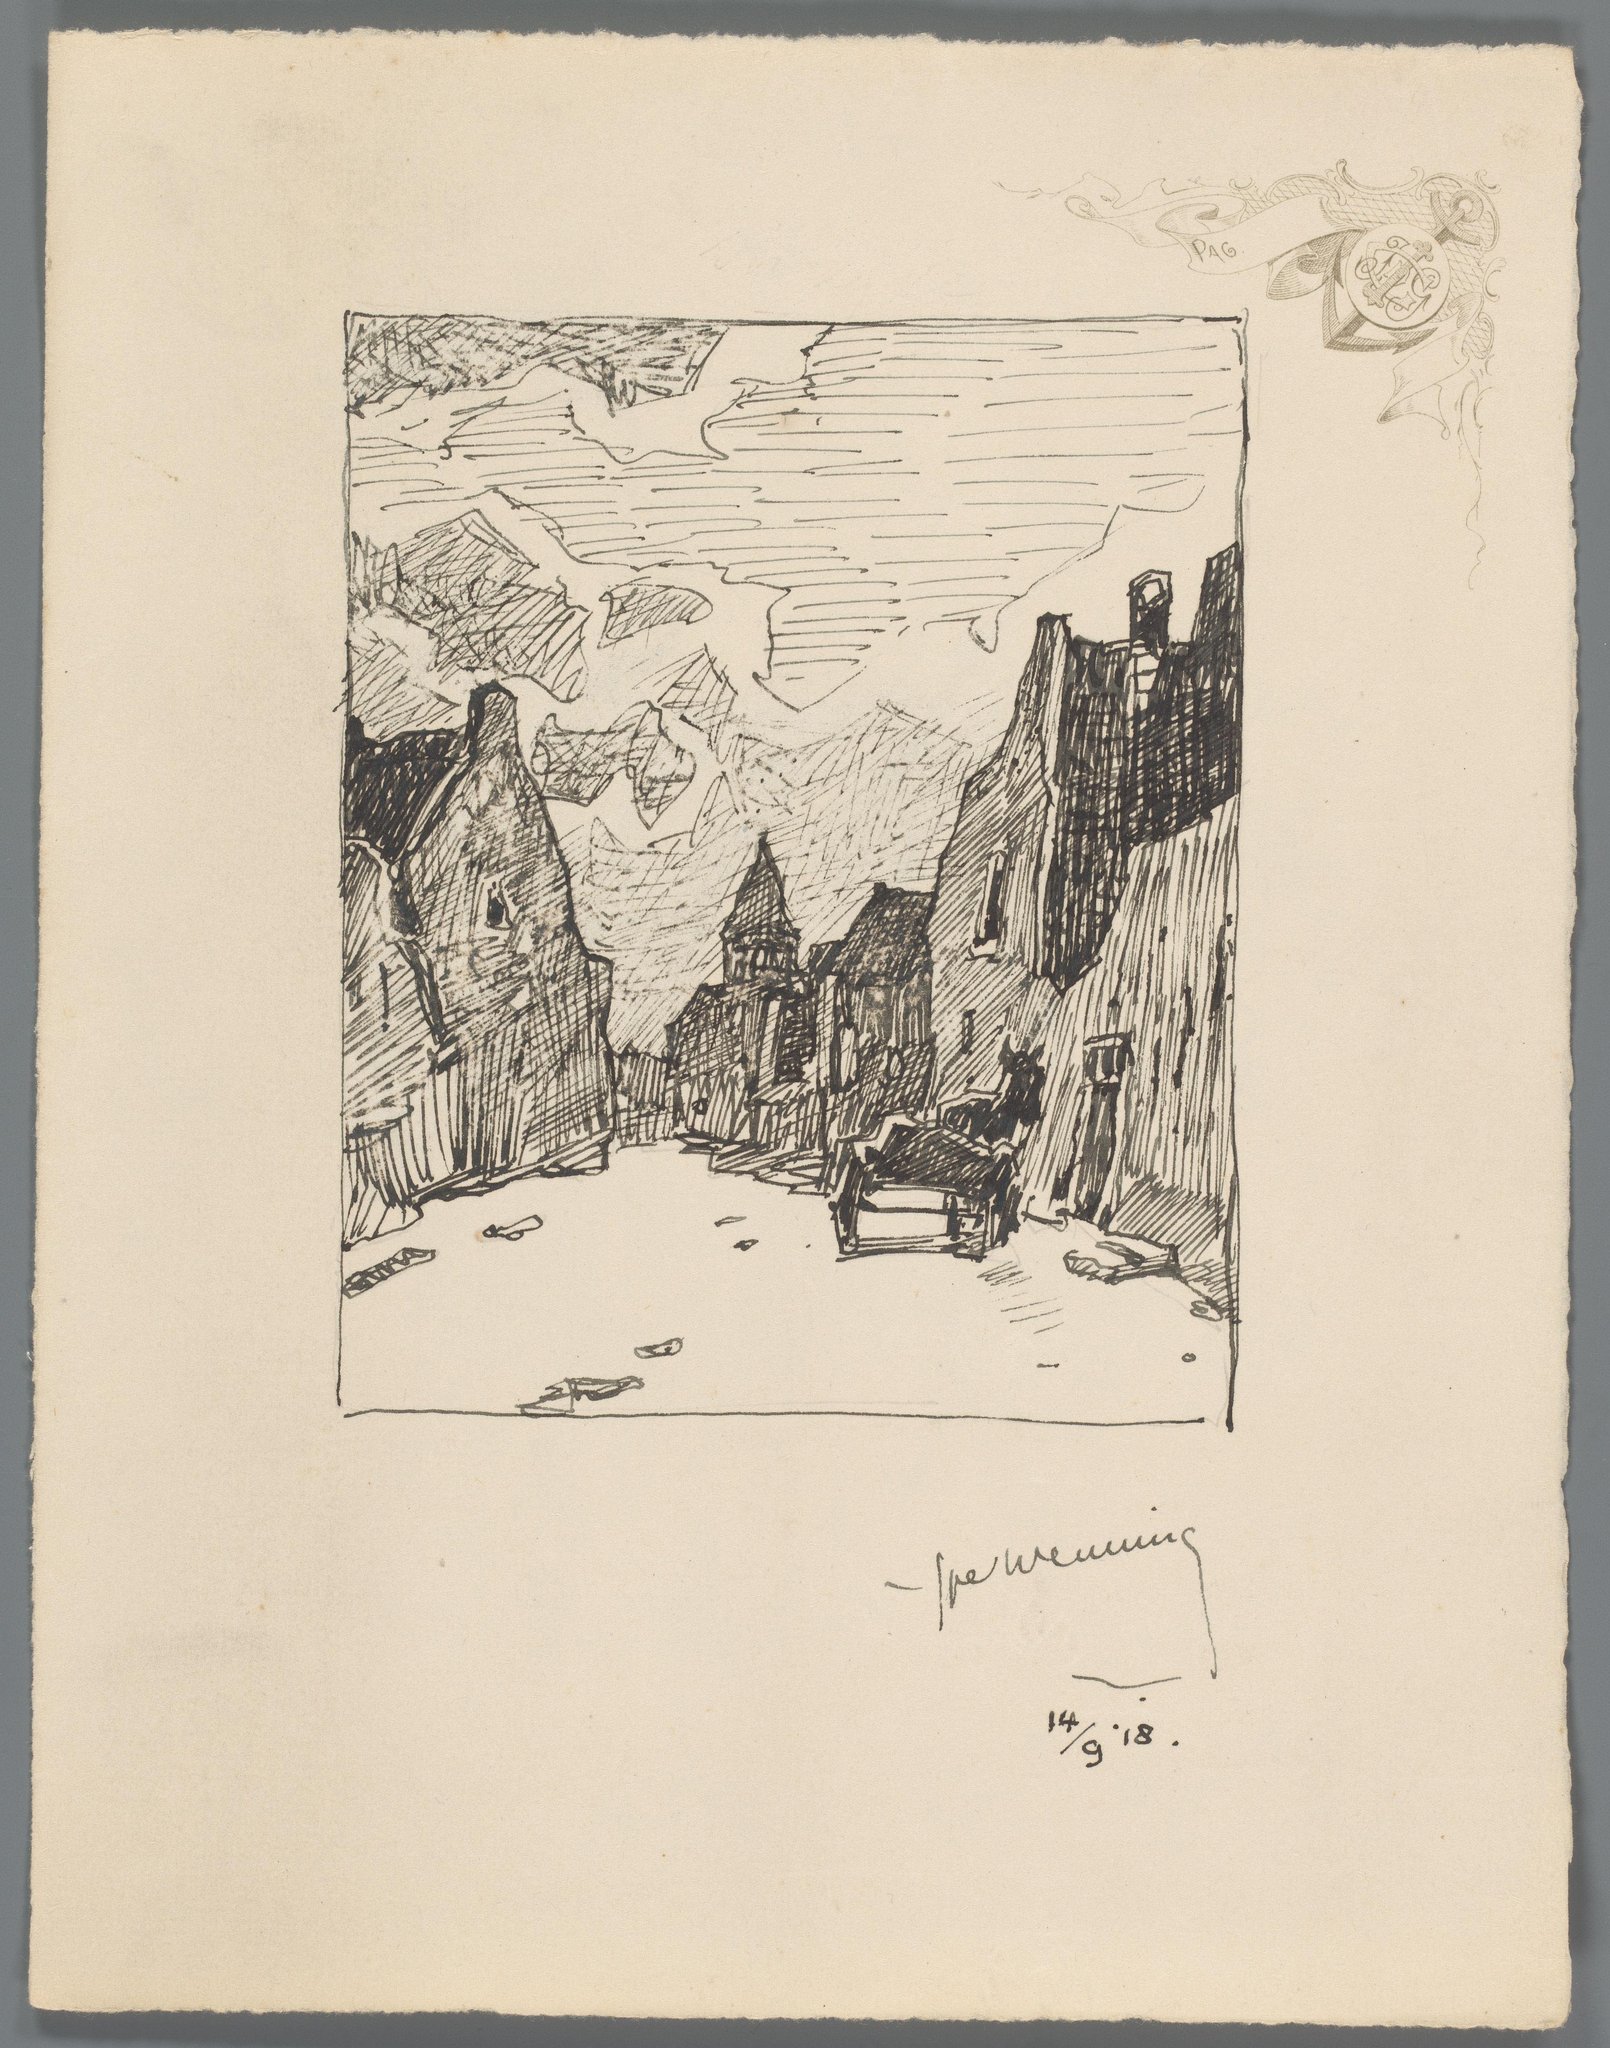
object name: drawing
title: Straat met huizen en een paard met wagen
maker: ype wenning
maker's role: painter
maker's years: 1879-1959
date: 1918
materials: ink, paper, pencil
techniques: lithograph, pen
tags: animal traction, animal-drawn vehicle (carriage etc.), village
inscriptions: date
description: Tekening op een blad met gepersonaliseerde decoratie in de vorm van een anker met monogram, met ruimte voor een paginanummer.